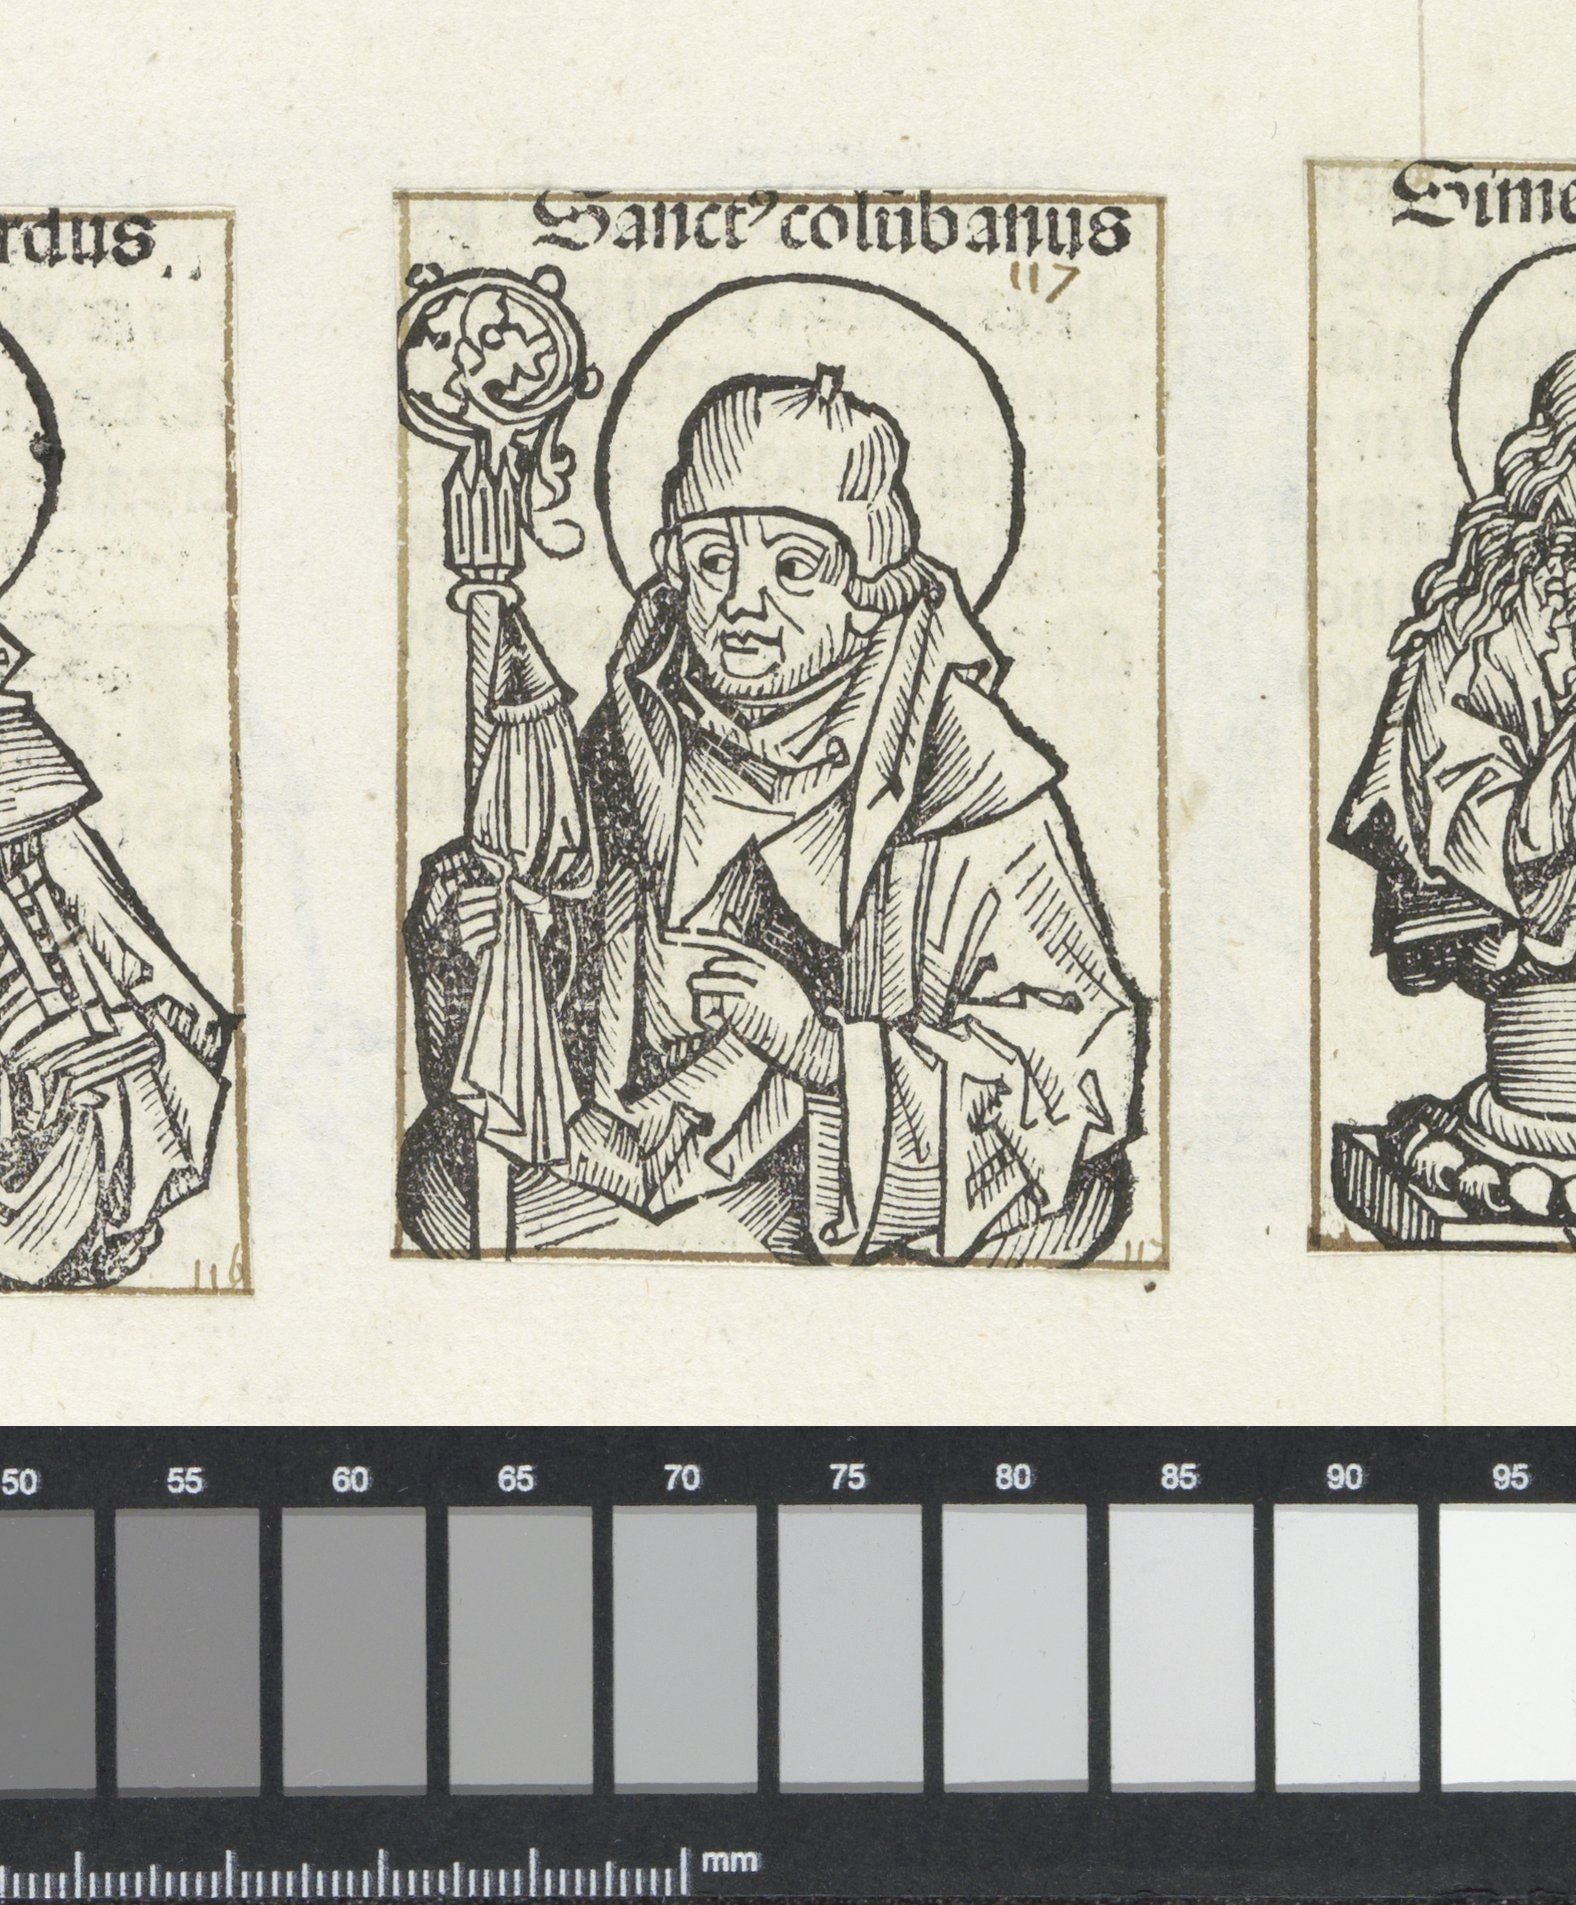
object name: book illustration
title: Heilige Columbanus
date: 1493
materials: paper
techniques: letterpress printing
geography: nuremberg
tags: male saints (with name)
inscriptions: inscription: ‘117’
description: De houtsnede wordt herhaaldelijk gebruikt als boekillustratie in de Liber Chronicarum (of Neurenbergkroniek) van Hartmann Schedel, verschenen in het Latijn en Duits in 1493. Zie de Latijnse uitgave, folio 146r.